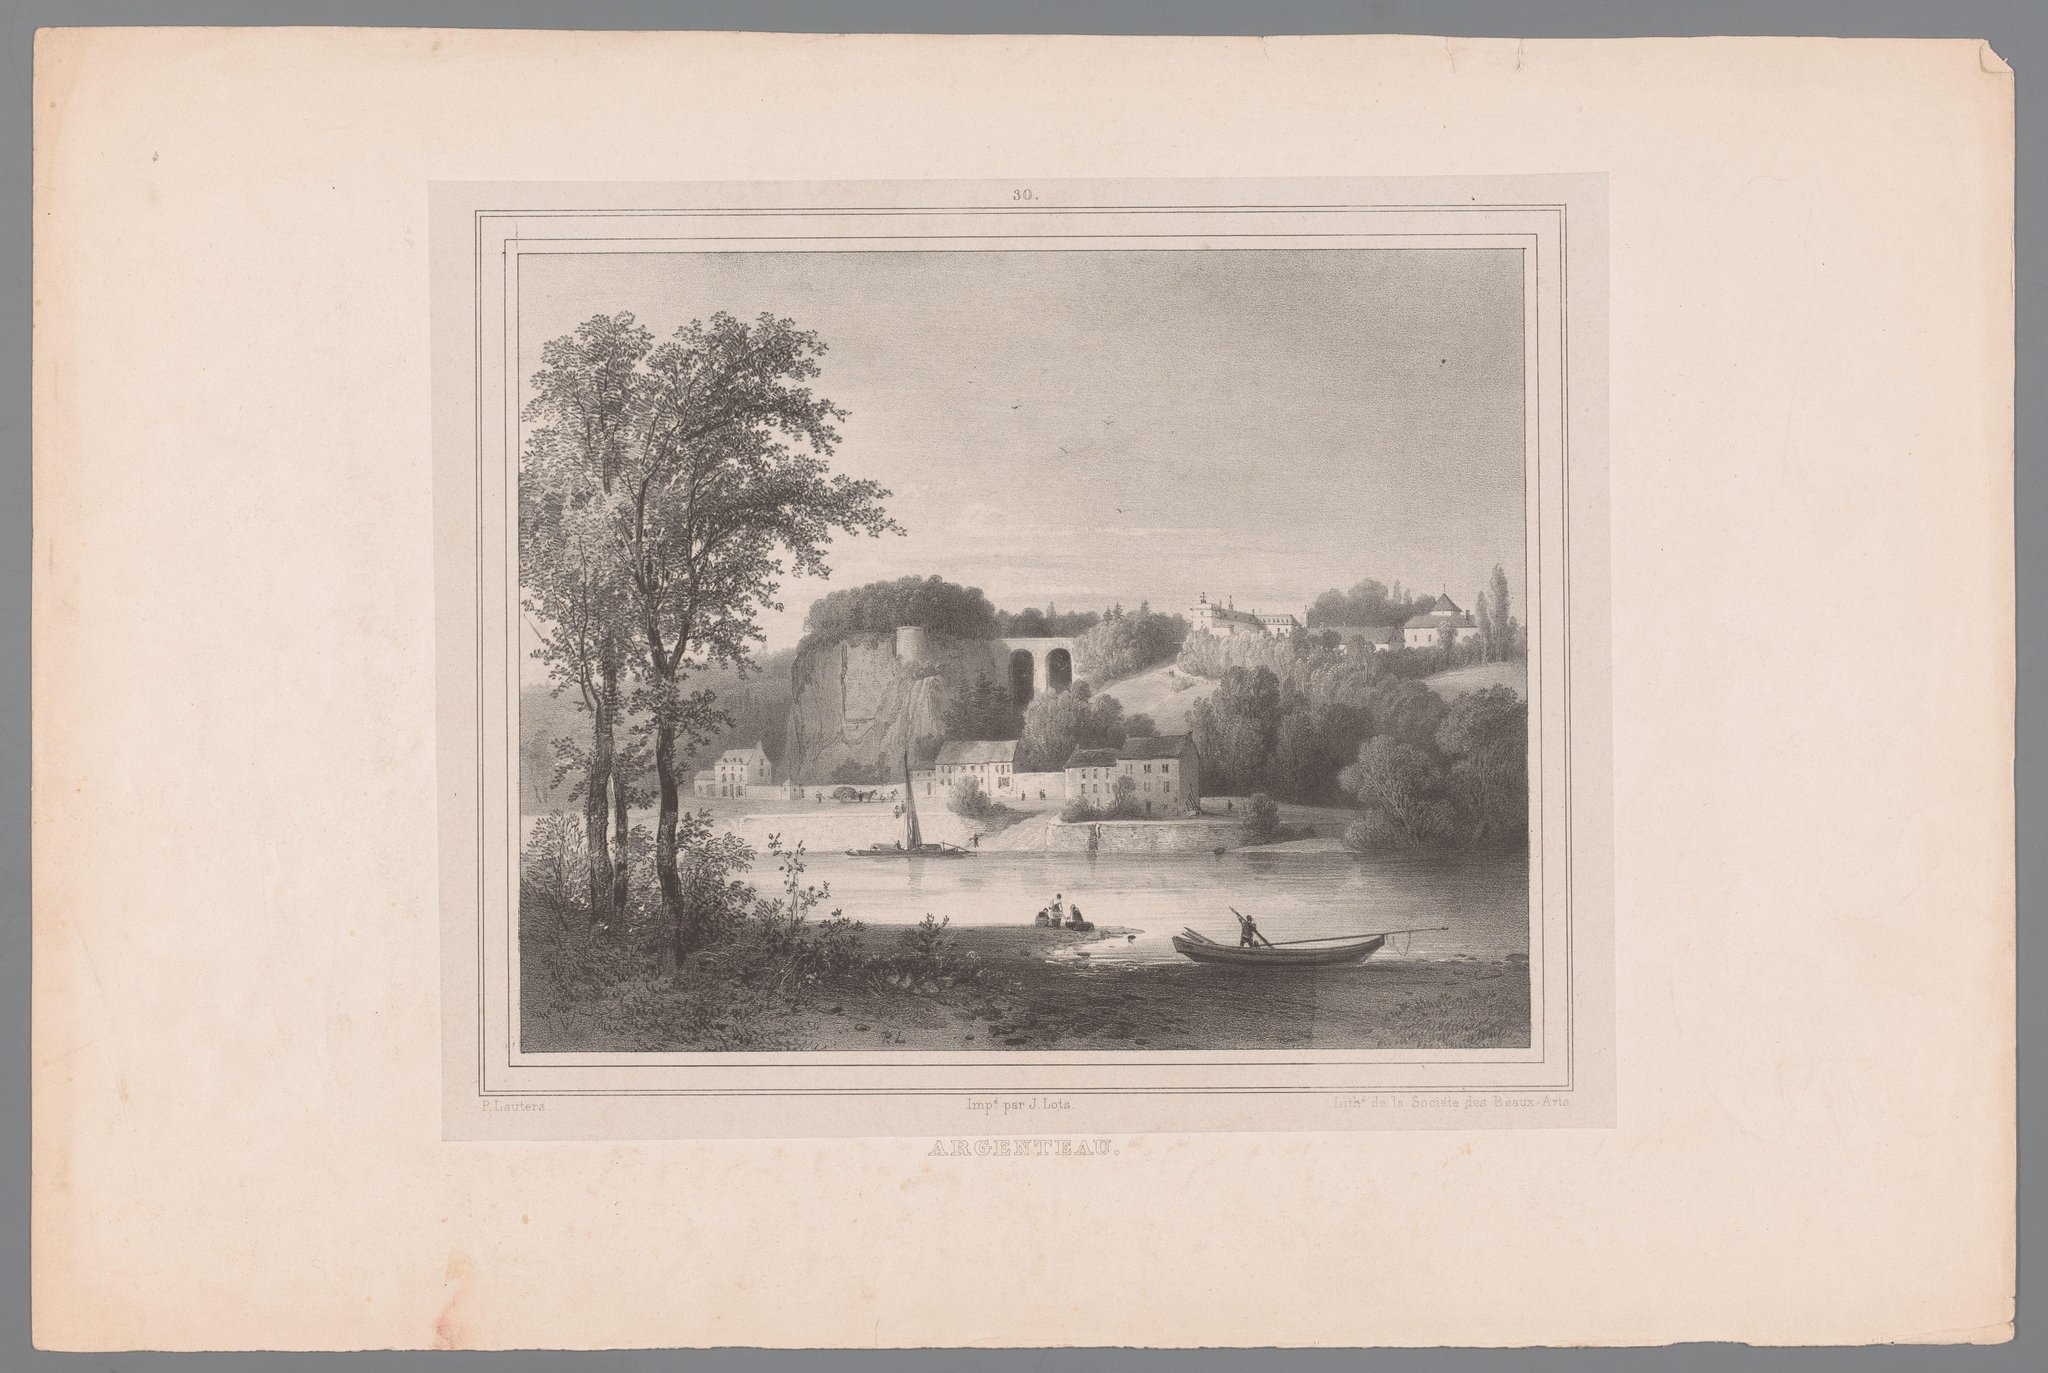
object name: print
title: Argenteau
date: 1839-1841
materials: paper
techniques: lithograph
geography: brussels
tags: prospect of village, silhouette of village, river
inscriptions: collector's mark: Lugt 2228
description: Prent verschenen in: Van Hasselt, André. Voyage aux bords de la Meuse. Brussel: Société des Beaux-Arts, 1839-1841. Deze publicatie bevat 36 litho's.